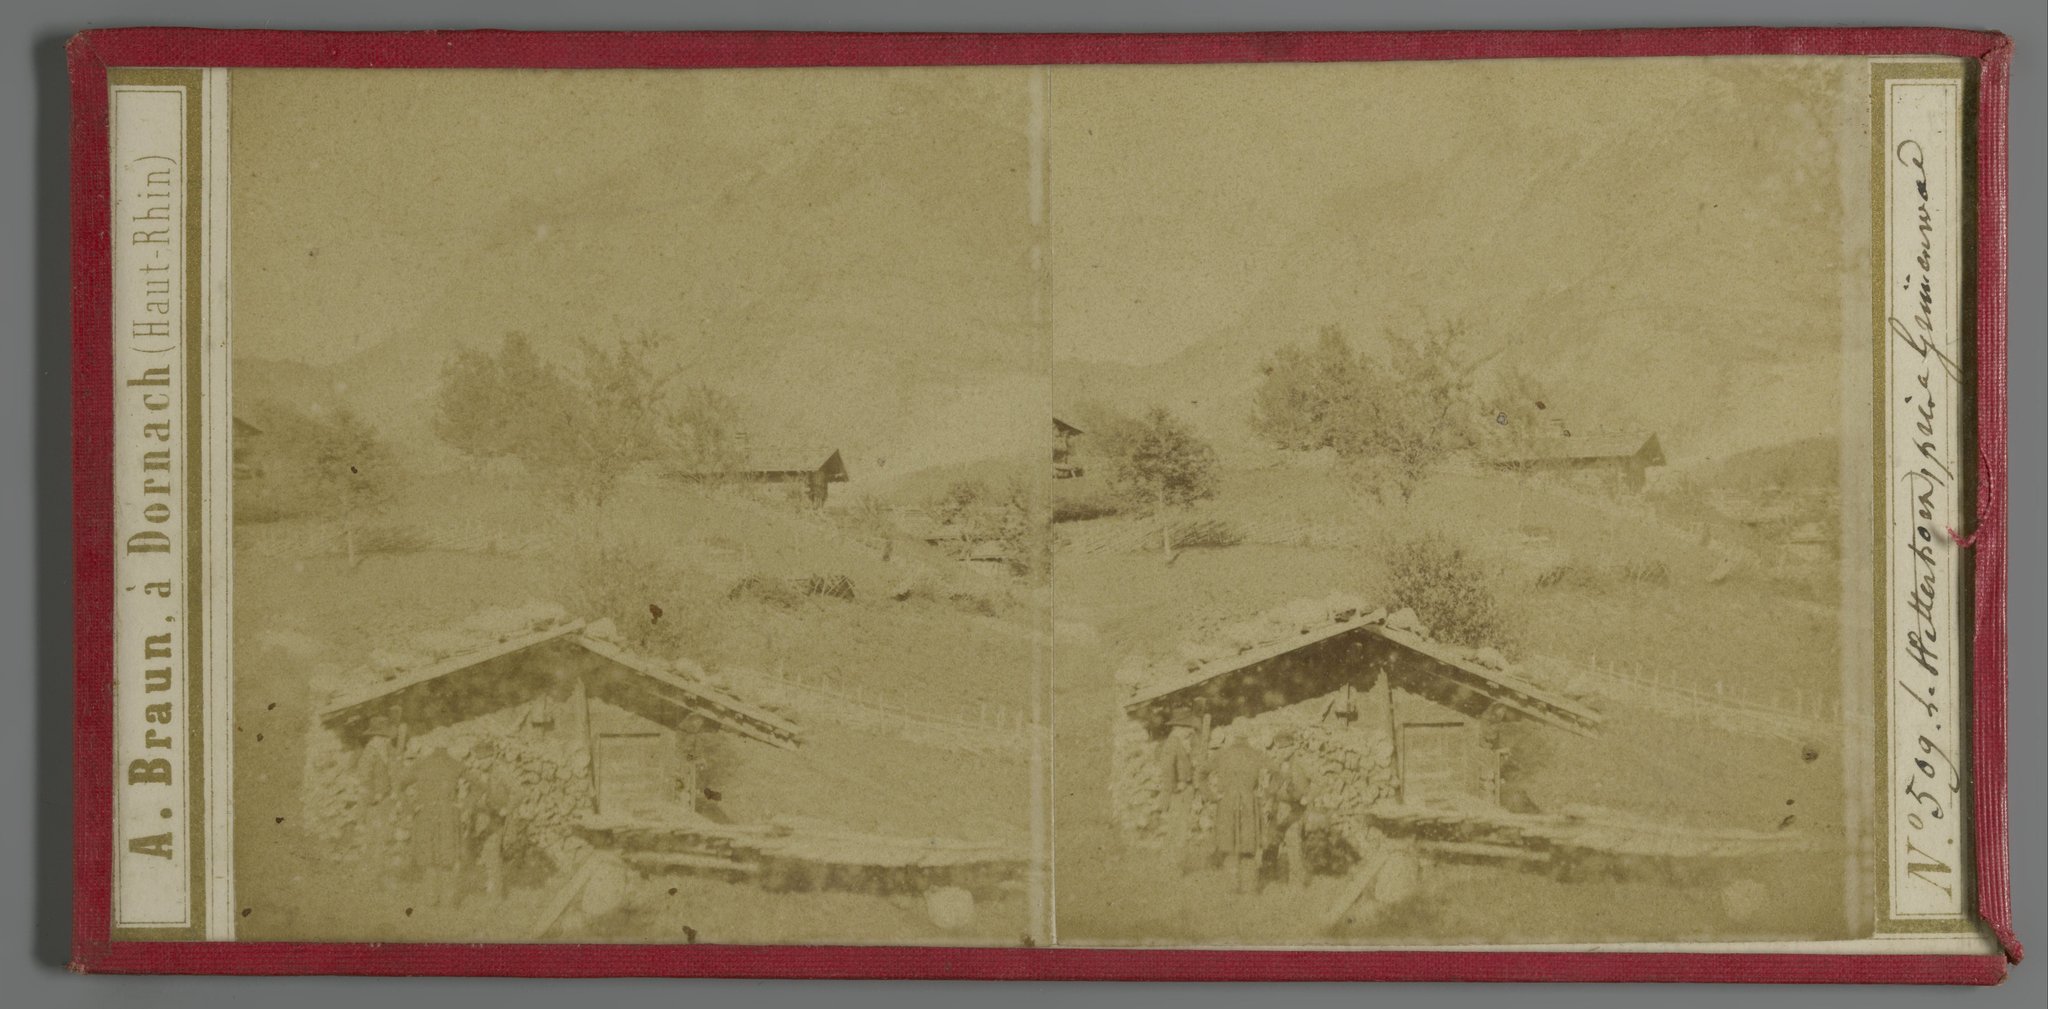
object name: stereoscopic photograph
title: Drie mannen voor een blokhut met op de achtergrond de Wetterhorn, Zwitserland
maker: andries jager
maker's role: publisher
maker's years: 1825-1905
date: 1860-1889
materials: cardboard, glass, paper, photographic support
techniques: albumen print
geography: switzerland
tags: log-cabin, mountains (+ landscape with figures, staffage)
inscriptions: inscription: ‘STEREOSKOPEN IN ALLE SOORTEN./ GROOT ASSORTIMENT VAN STEREOSKOPISCHE VOORWERPEN/ OP ZILVER, GLAS EN PAPIER./ A. JAGER, Water 110, Amsterdam./ GEZIGTEN van Amsterdam (...) voor Stereoskopen, enz.’, annotation: ‘No. 509. Le Wetterhorn, pres à Grindelwald’, inscription: ‘A. Braun, à Dornach (Haut-Rhin)’, name: ‘M L P Kistemaker’